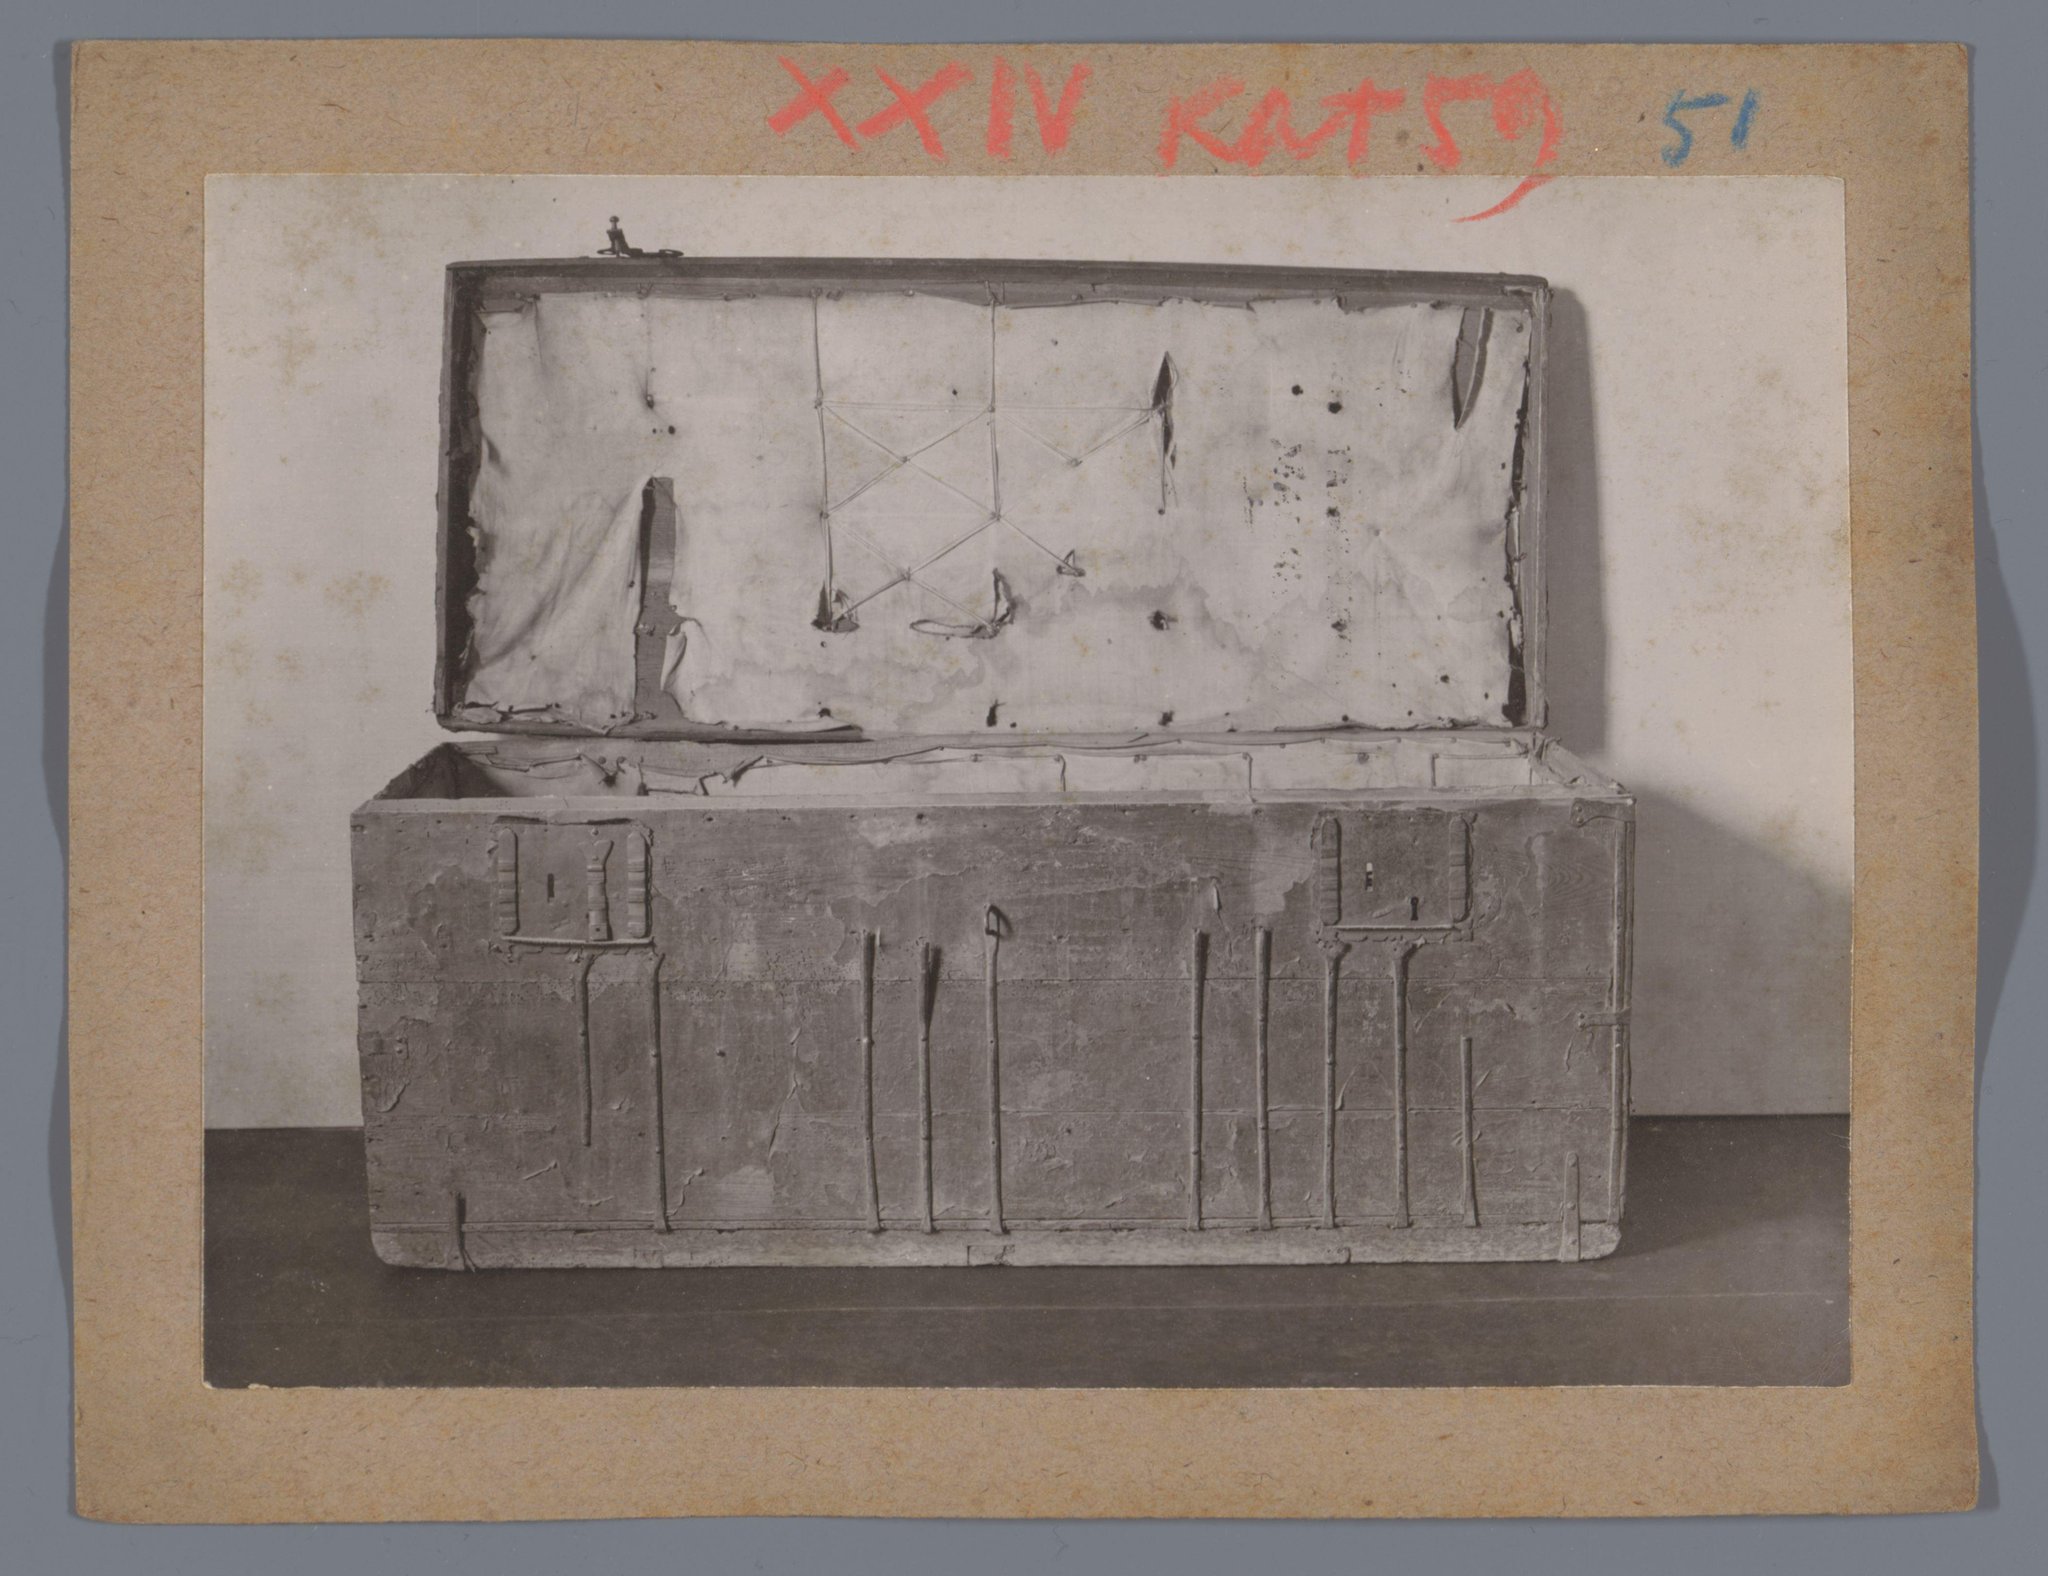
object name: photograph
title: Kist met een open deksel (vermoedelijk) in het Rijksmuseum te Amsterdam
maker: Anonymous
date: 1875-1900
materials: photographic support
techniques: matte daylight collodion silver print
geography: amsterdam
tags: chest, coffer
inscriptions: number: ‘XXIV Kat 59 51’, collector's mark: ‘Instituut voor kunst-nijverheidsonderwijs Gabriël Metsustraat No. 16, Amsterdam’, collector's mark: ‘Kunstnijverheidschool Quellinus Amsterdam Frans Halsstraat 14.’